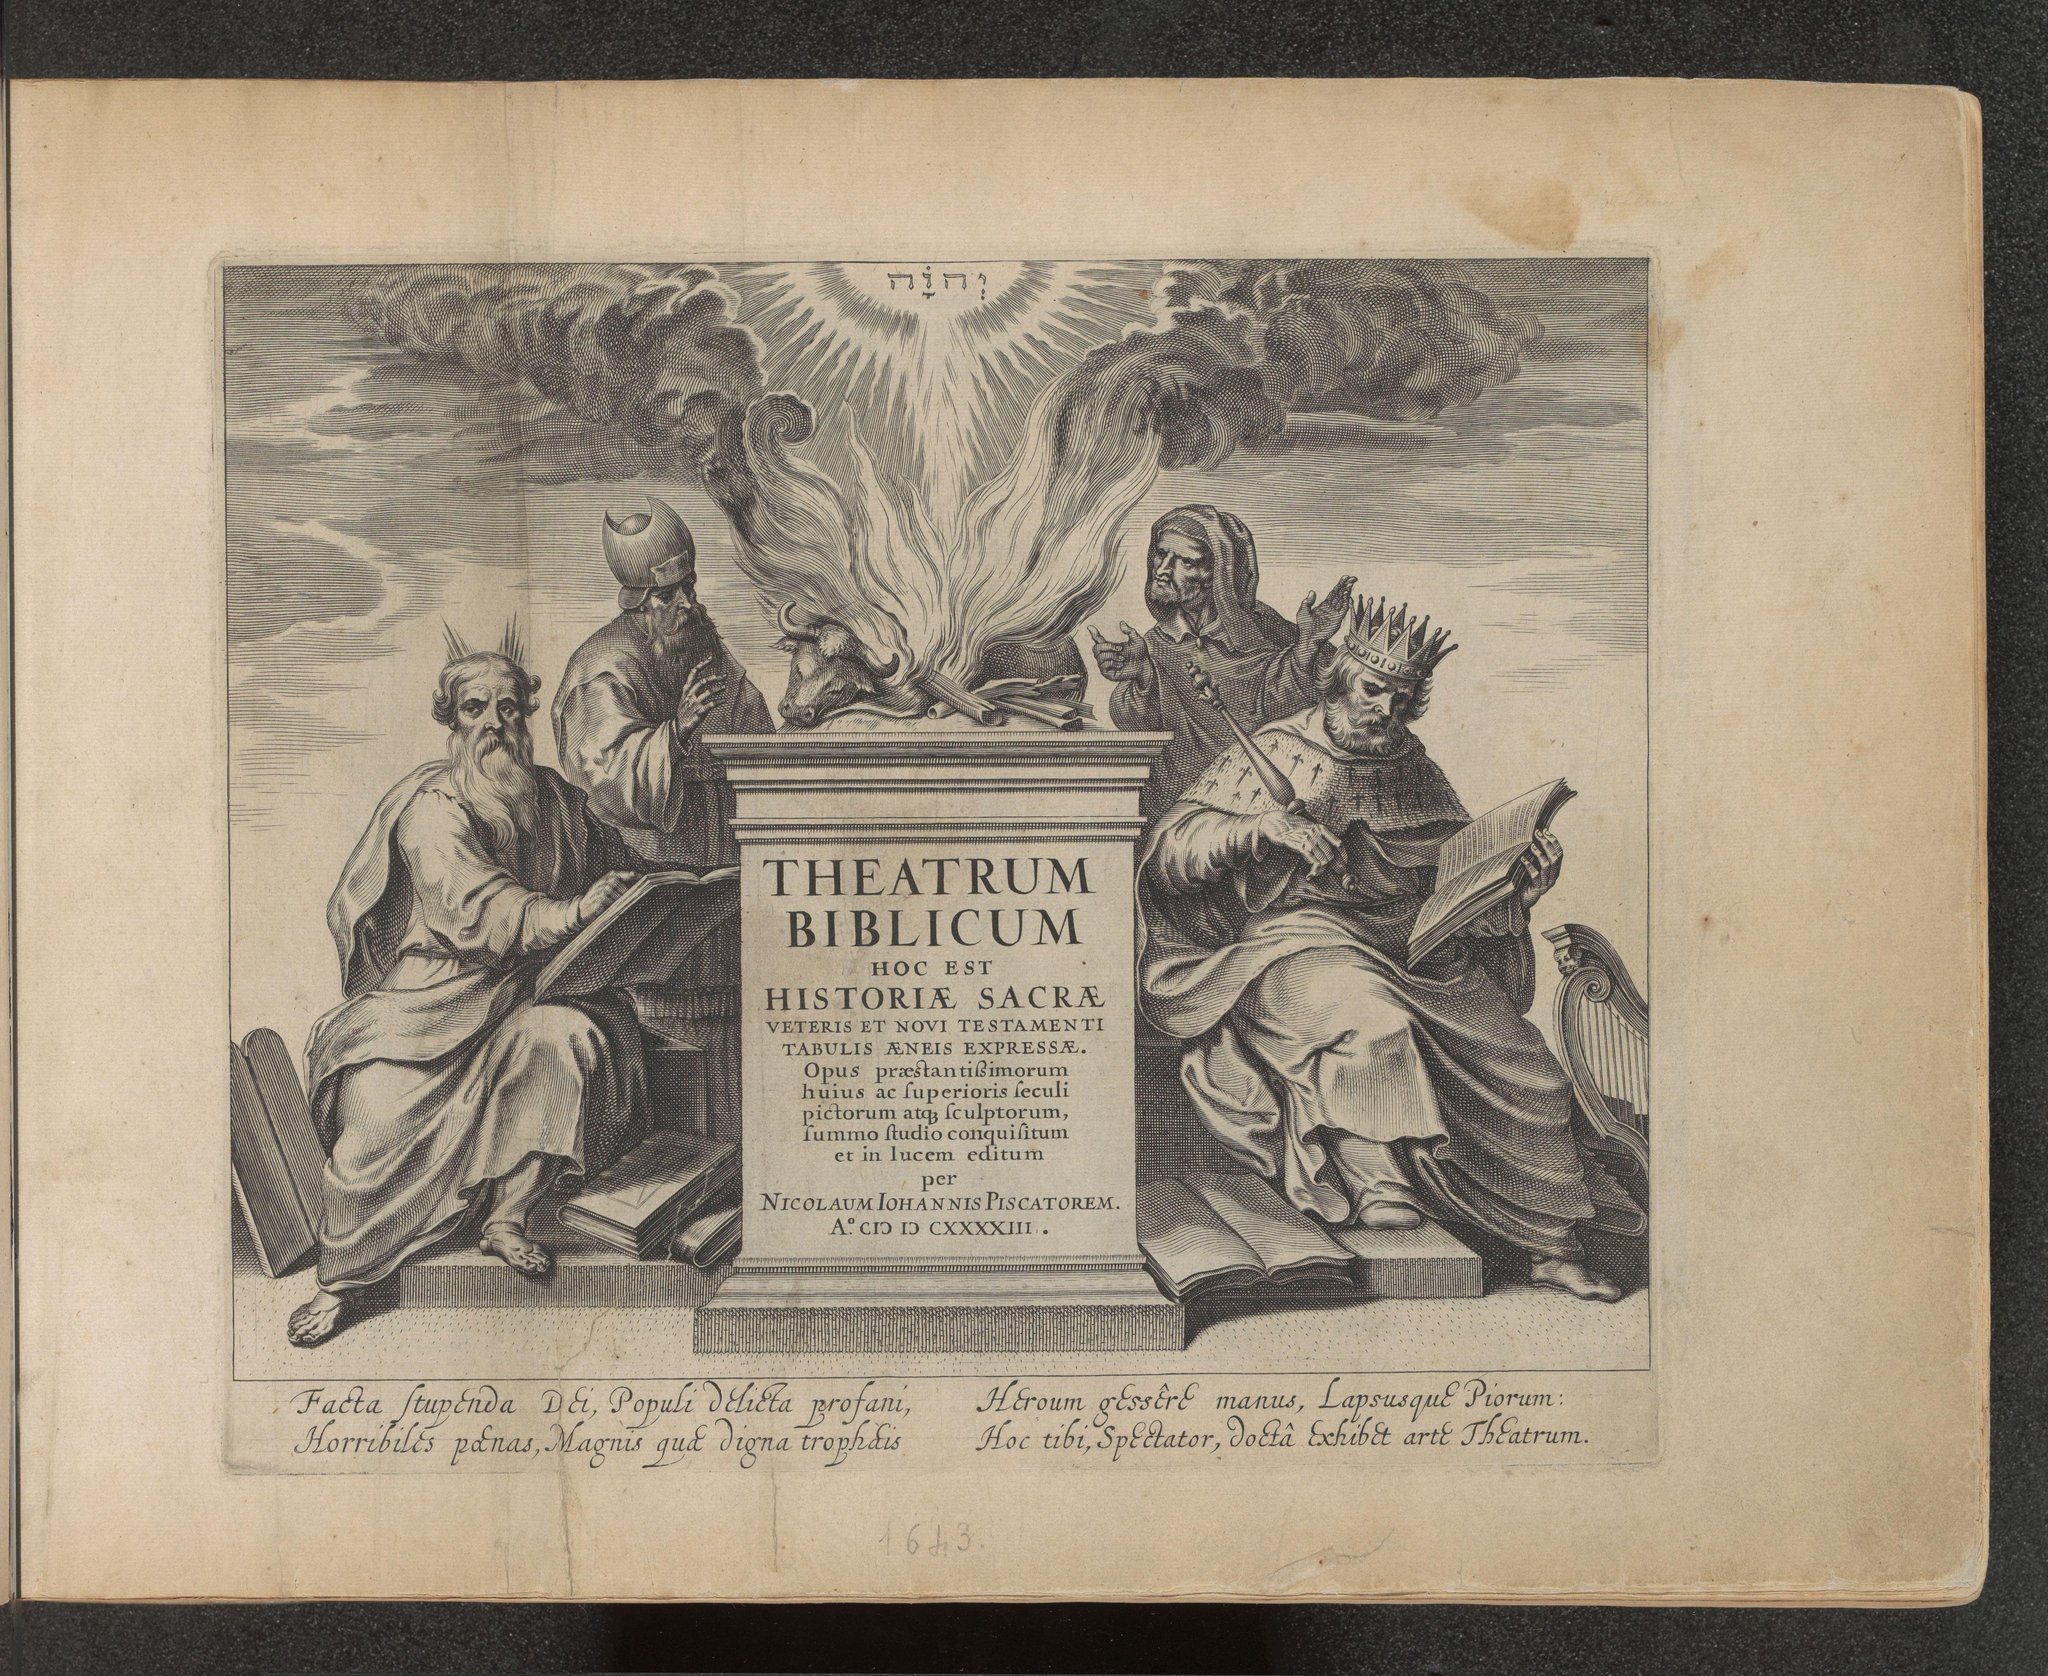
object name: album leaf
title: Mozes, Aäron en koning David bij een offerzuil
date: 1643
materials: paper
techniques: engraving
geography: amsterdam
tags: david (not in biblical context); possible attributes: crown, harp, aaron (not in biblical context); possible attributes: attributes of aaron: censer, dressed as high priest or bishop, ointment jar, rod or flowering wand, moses (not in biblical context); possible attributes: rays of light or horns on his head, rod, tables of the law, aaron offers sacrifices (leviticus 9)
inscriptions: collector's mark: Lugt 2228, collector's mark: Lugt 2760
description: Titelprent voor 'Theatrum biblicum' met de titel op een offerzuil, waarop een brandend kalf ligt. Links Mozes met de tien geboden en de hogepriester Aäron. Rechts een profeet en koning David met zijn harp. Onder de voorstelling een tekst in het Latijn. Deze prent maakt deel uit van een album.